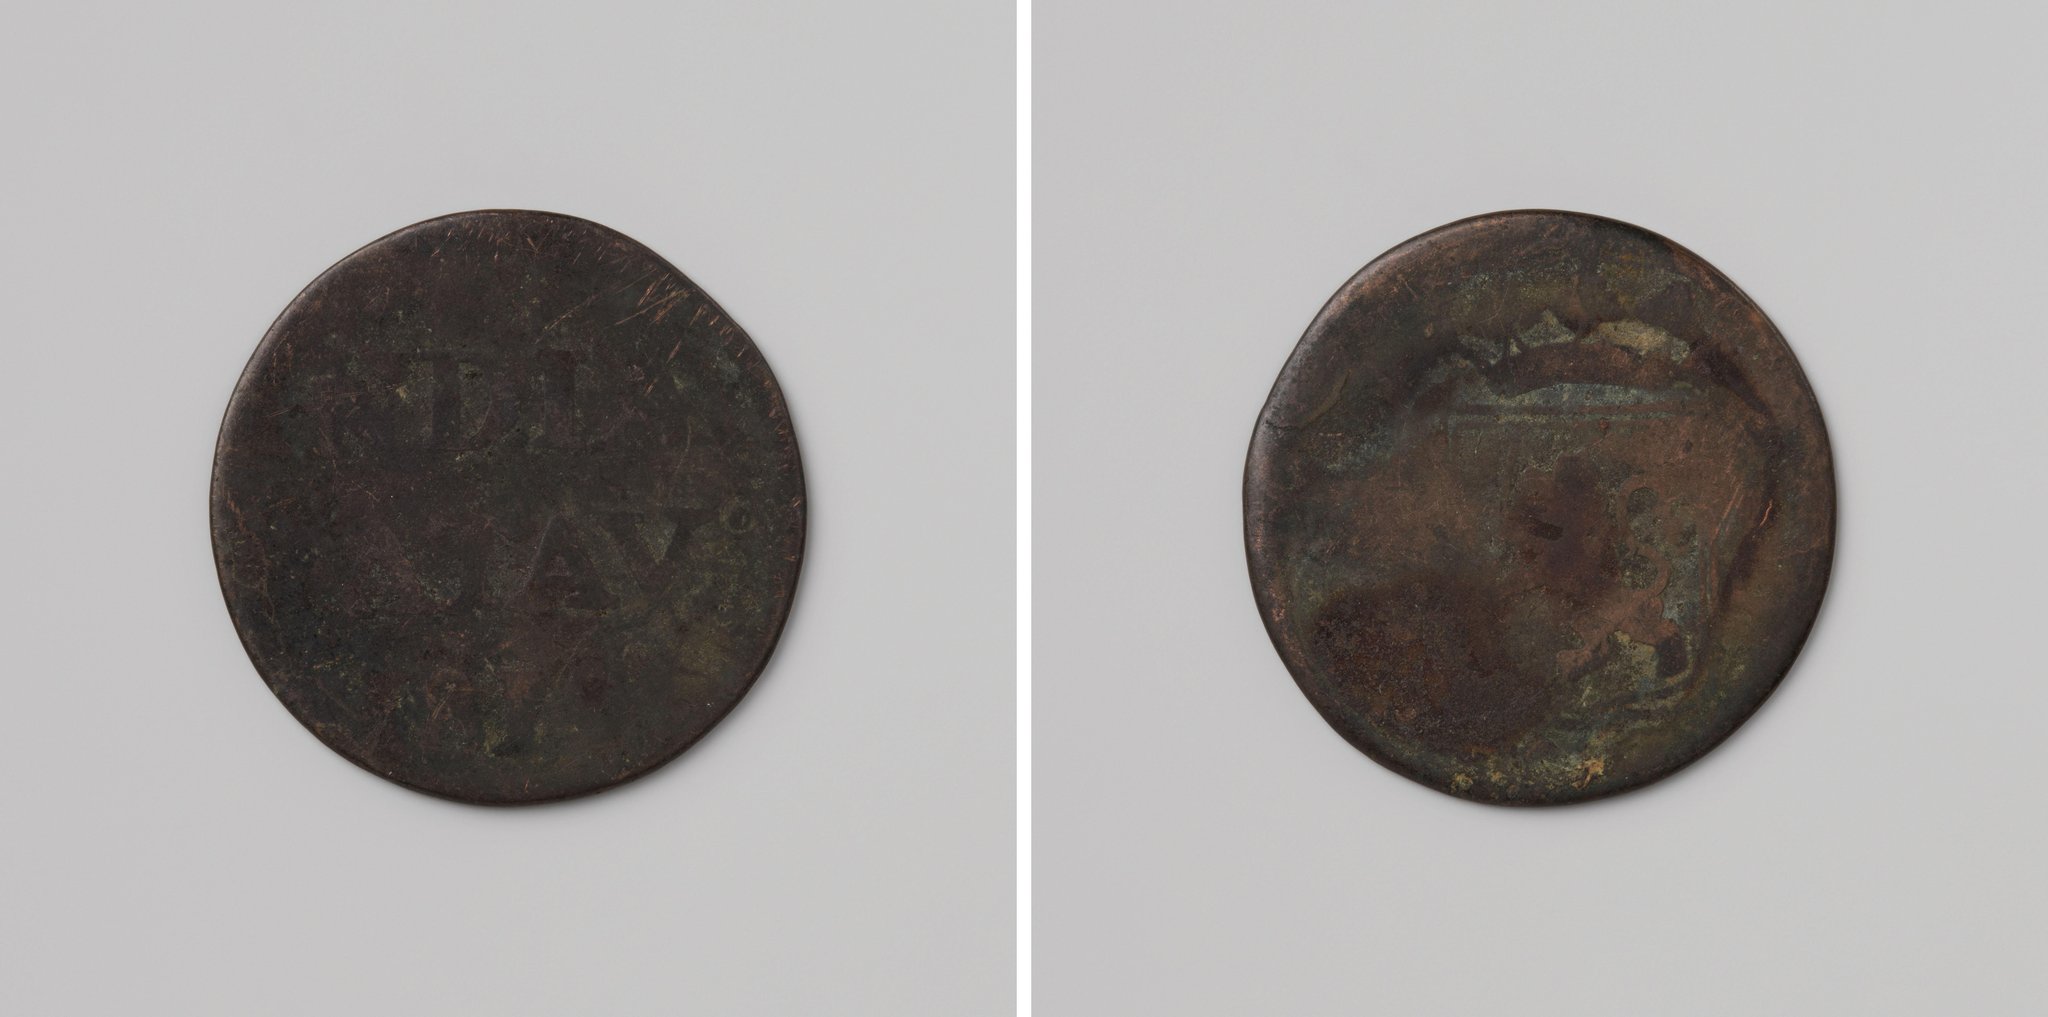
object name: coin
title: Koperen cent VOC-munt uit Nederlands-Indië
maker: Anonymous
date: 1819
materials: copper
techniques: striking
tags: dutch east indies, the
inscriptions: inscription: ‘..NDIA / ..ATAV / 1819’, inscription: ‘Jacques Schulman / Numismaat / Keizersgracht 448 / Amsterdam-C.’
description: Koperen cent VOC-muntje uit Nederlands-Indië, waarschijnlijk uit1819. Voorzijde: opschrift. Keerzijde: een gekroond wapen met leeuw erin en rechts ervan staan de letters . Het muntje zit in een vierkant envelopje met opschrift.